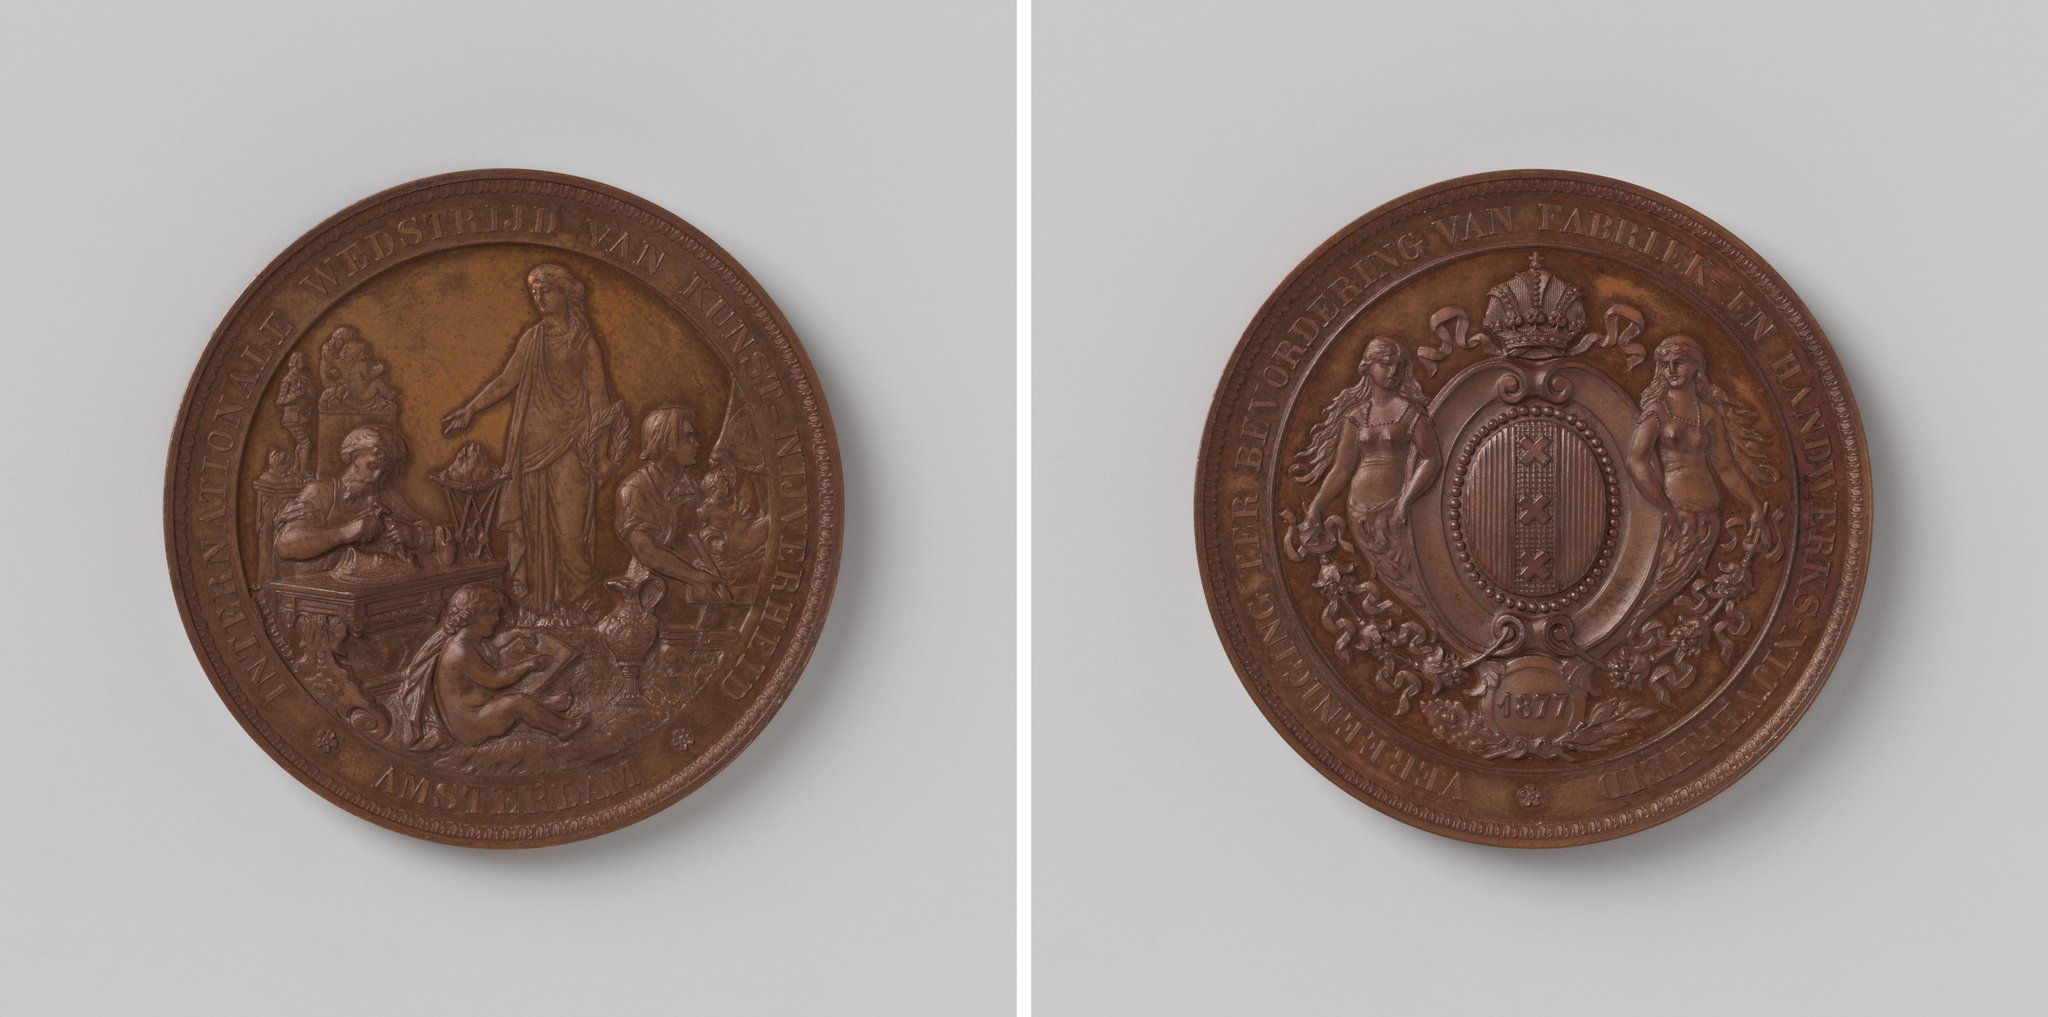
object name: medal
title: Tentoonstelling Kunst toegepast op Nijverheid te Amsterdam, georganiseerd ter ere van het vijfentwintigjarig bestaan van de Vereeniging ter bevordering van Fabriek- en Handwerksnijverheid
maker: jacob samuel cohen elion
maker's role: draughtsman, painter, print maker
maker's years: 1840-1893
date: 1877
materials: bronze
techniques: striking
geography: amsterdam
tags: amsterdam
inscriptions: signature: ‘J.ELION.F.’, date: ‘1877’, circumscription: ‘INTERNATIONALE WEDSTRIJD VAN KUNST- NIJVERHEID’, circumscription: ‘VEREENIGING TER BEVORDERING VAN FABRIEK - EN HANDSWERKS - NIJVERHEID’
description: Bronzen penning. Voorzijde: atelier, waar onder toeziend oog van Minerva twee mannen en kind zich wijden aan verschillende takken van nijverheid. Keerzijde: gekroond wapenschild, omgeven door cartouche, geflankeerd door twee zeemeerminnen, voorstellend Kunst en Nijverheid, die gezamelijk bladerkrans vasthouden boven cartouche met jaartal binnen omschrift.